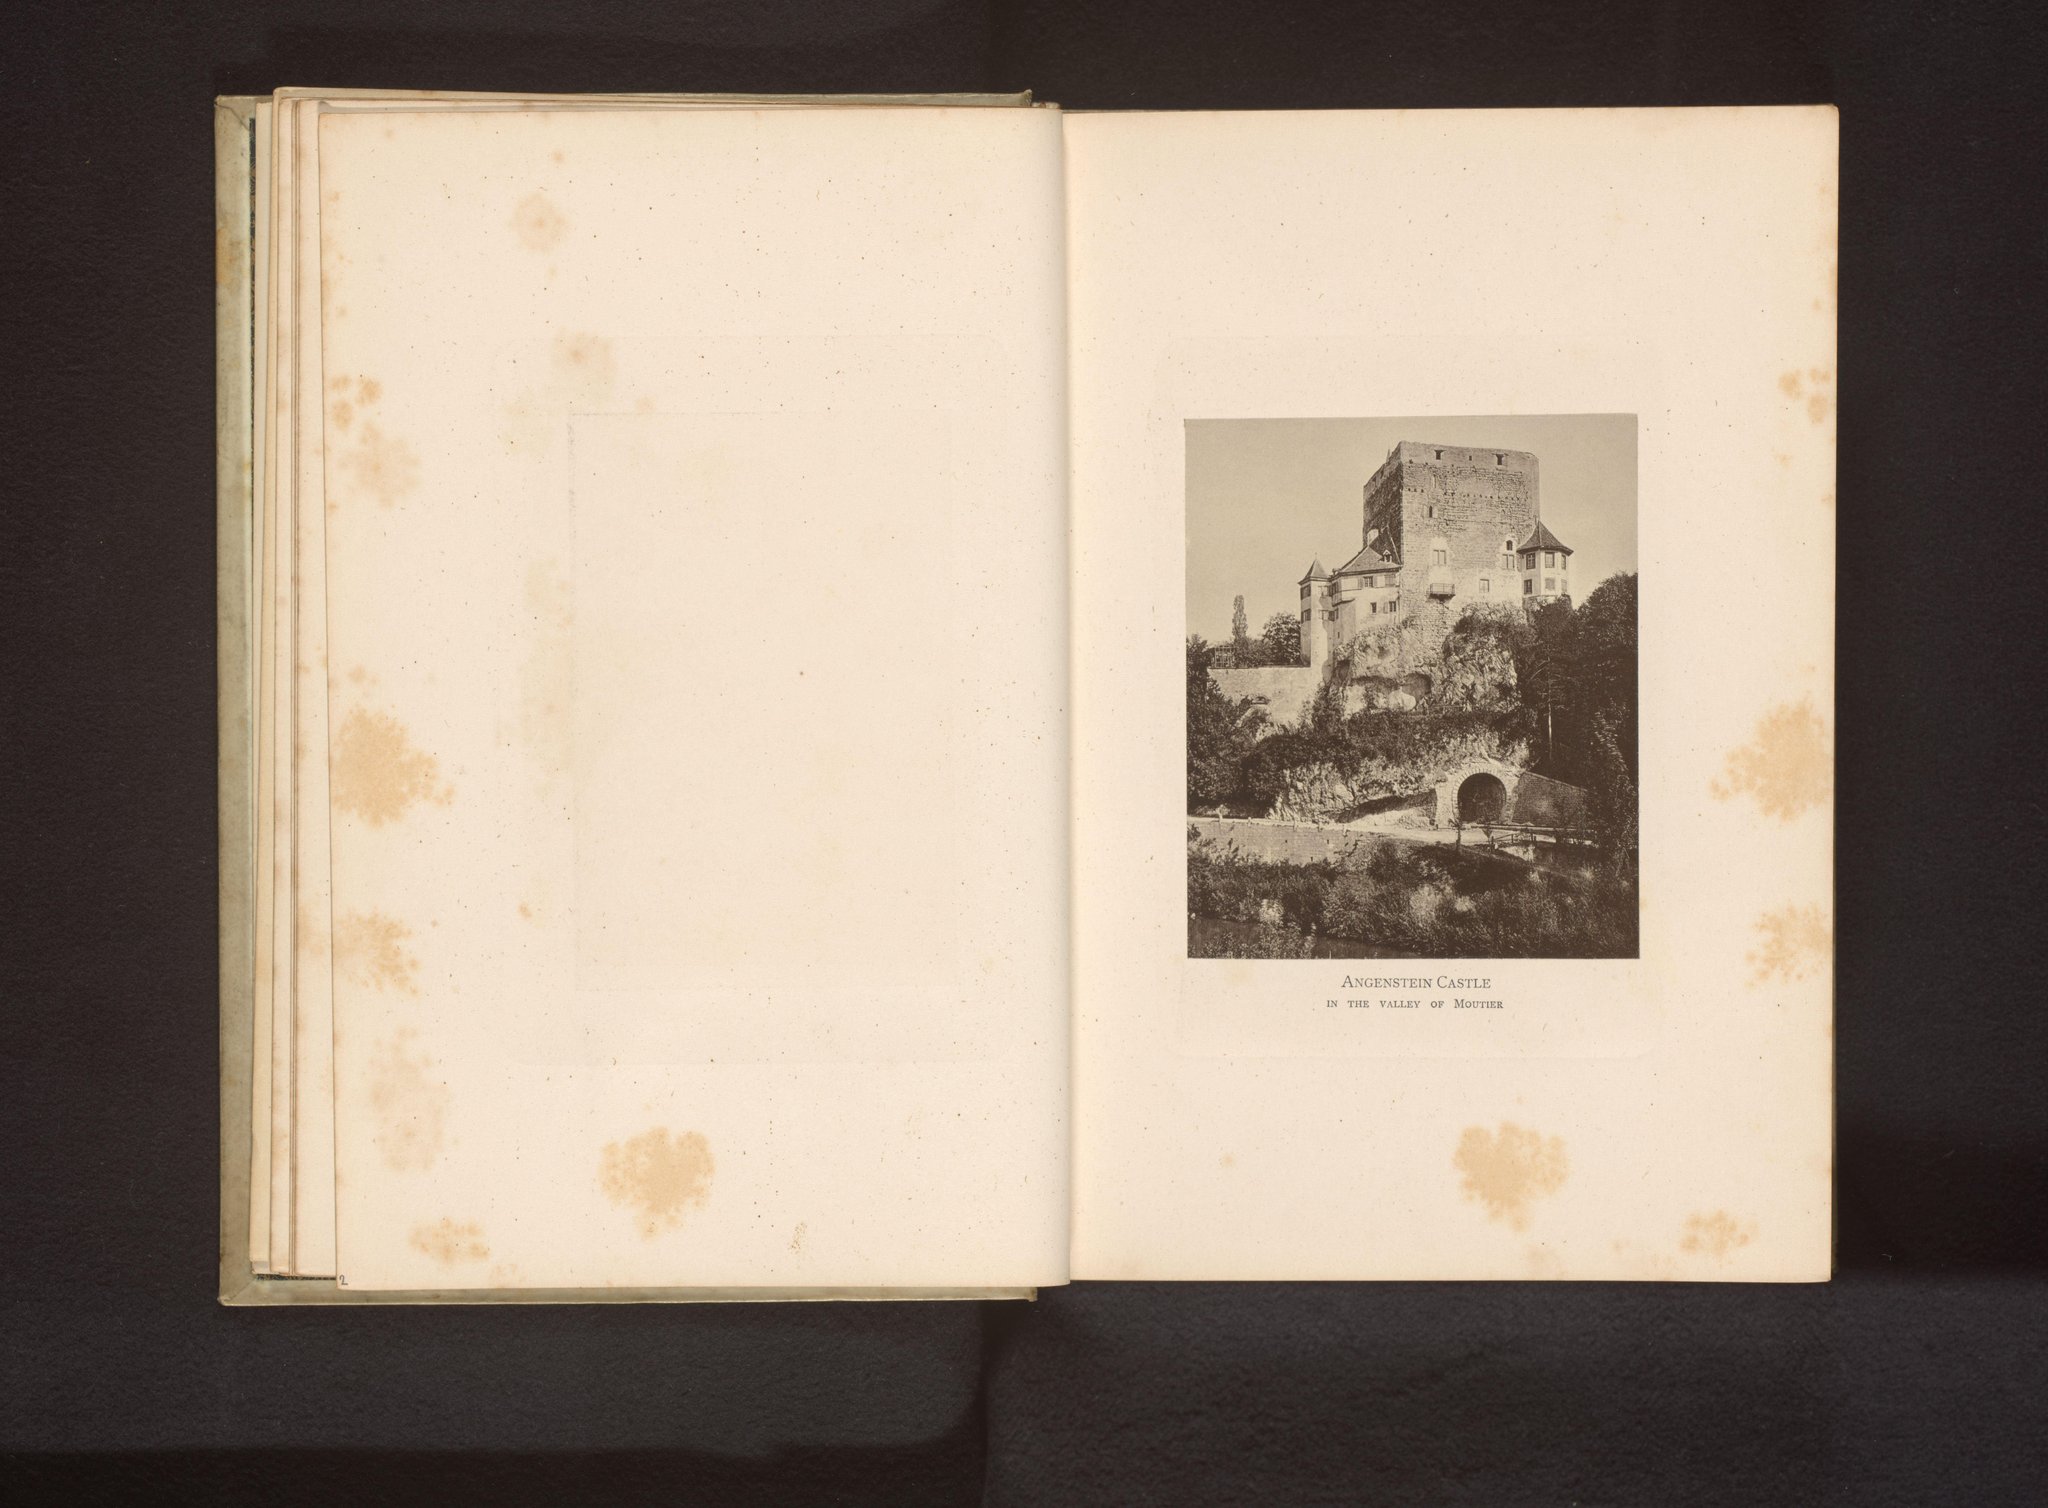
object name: page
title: Angenstein Castle in the Valley of Moutier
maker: Anonymous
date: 1874-1884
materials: paper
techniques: photograph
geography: basel-landschaft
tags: castle